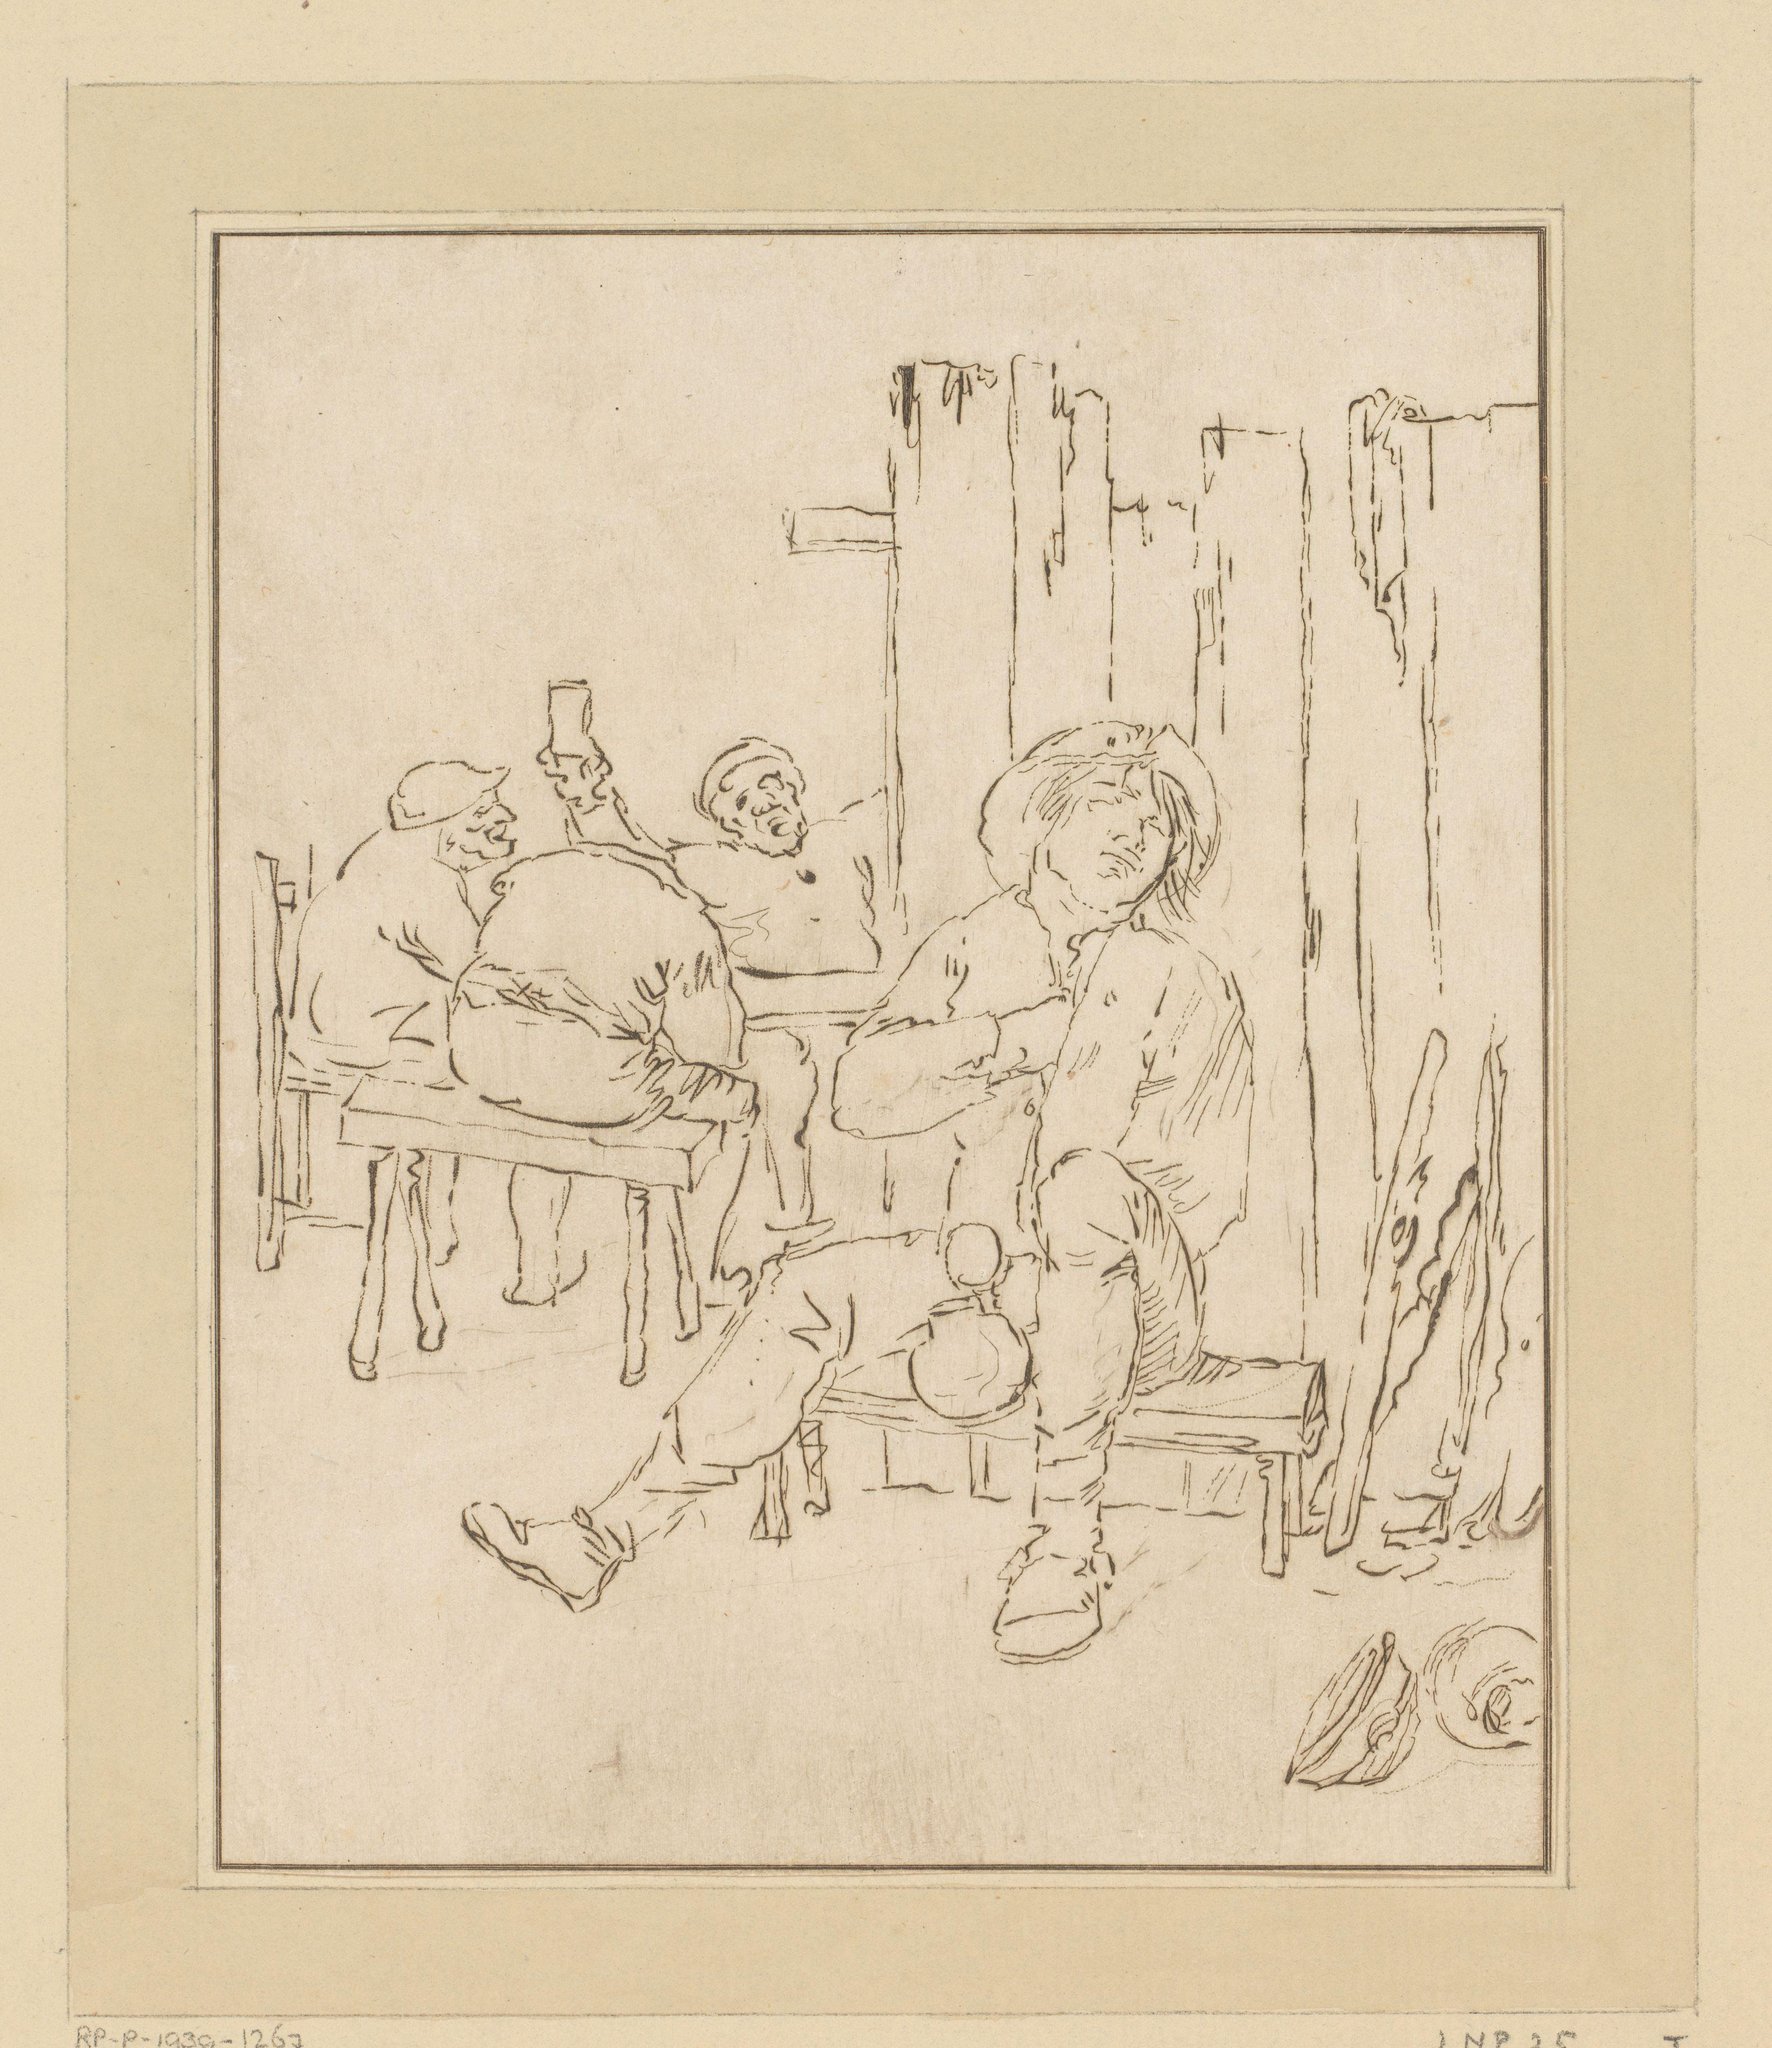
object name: print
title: Dronken boer in herberg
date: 1775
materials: paper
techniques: etching, roulette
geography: amsterdam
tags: inn, coffee-house, public house, etc., jar, jug (used as drinking-vessel), drinking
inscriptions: collector's mark: ‘RIJKS / MUSM’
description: Een boer zit op een lage bank in een herberg, met een kruik in zijn hand. Op de achtergrond drie mannen aan een tafel. De prent ligt los in een album, zie blad 25.